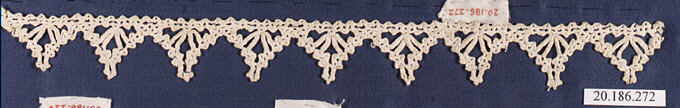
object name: edging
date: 1501-1600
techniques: lace